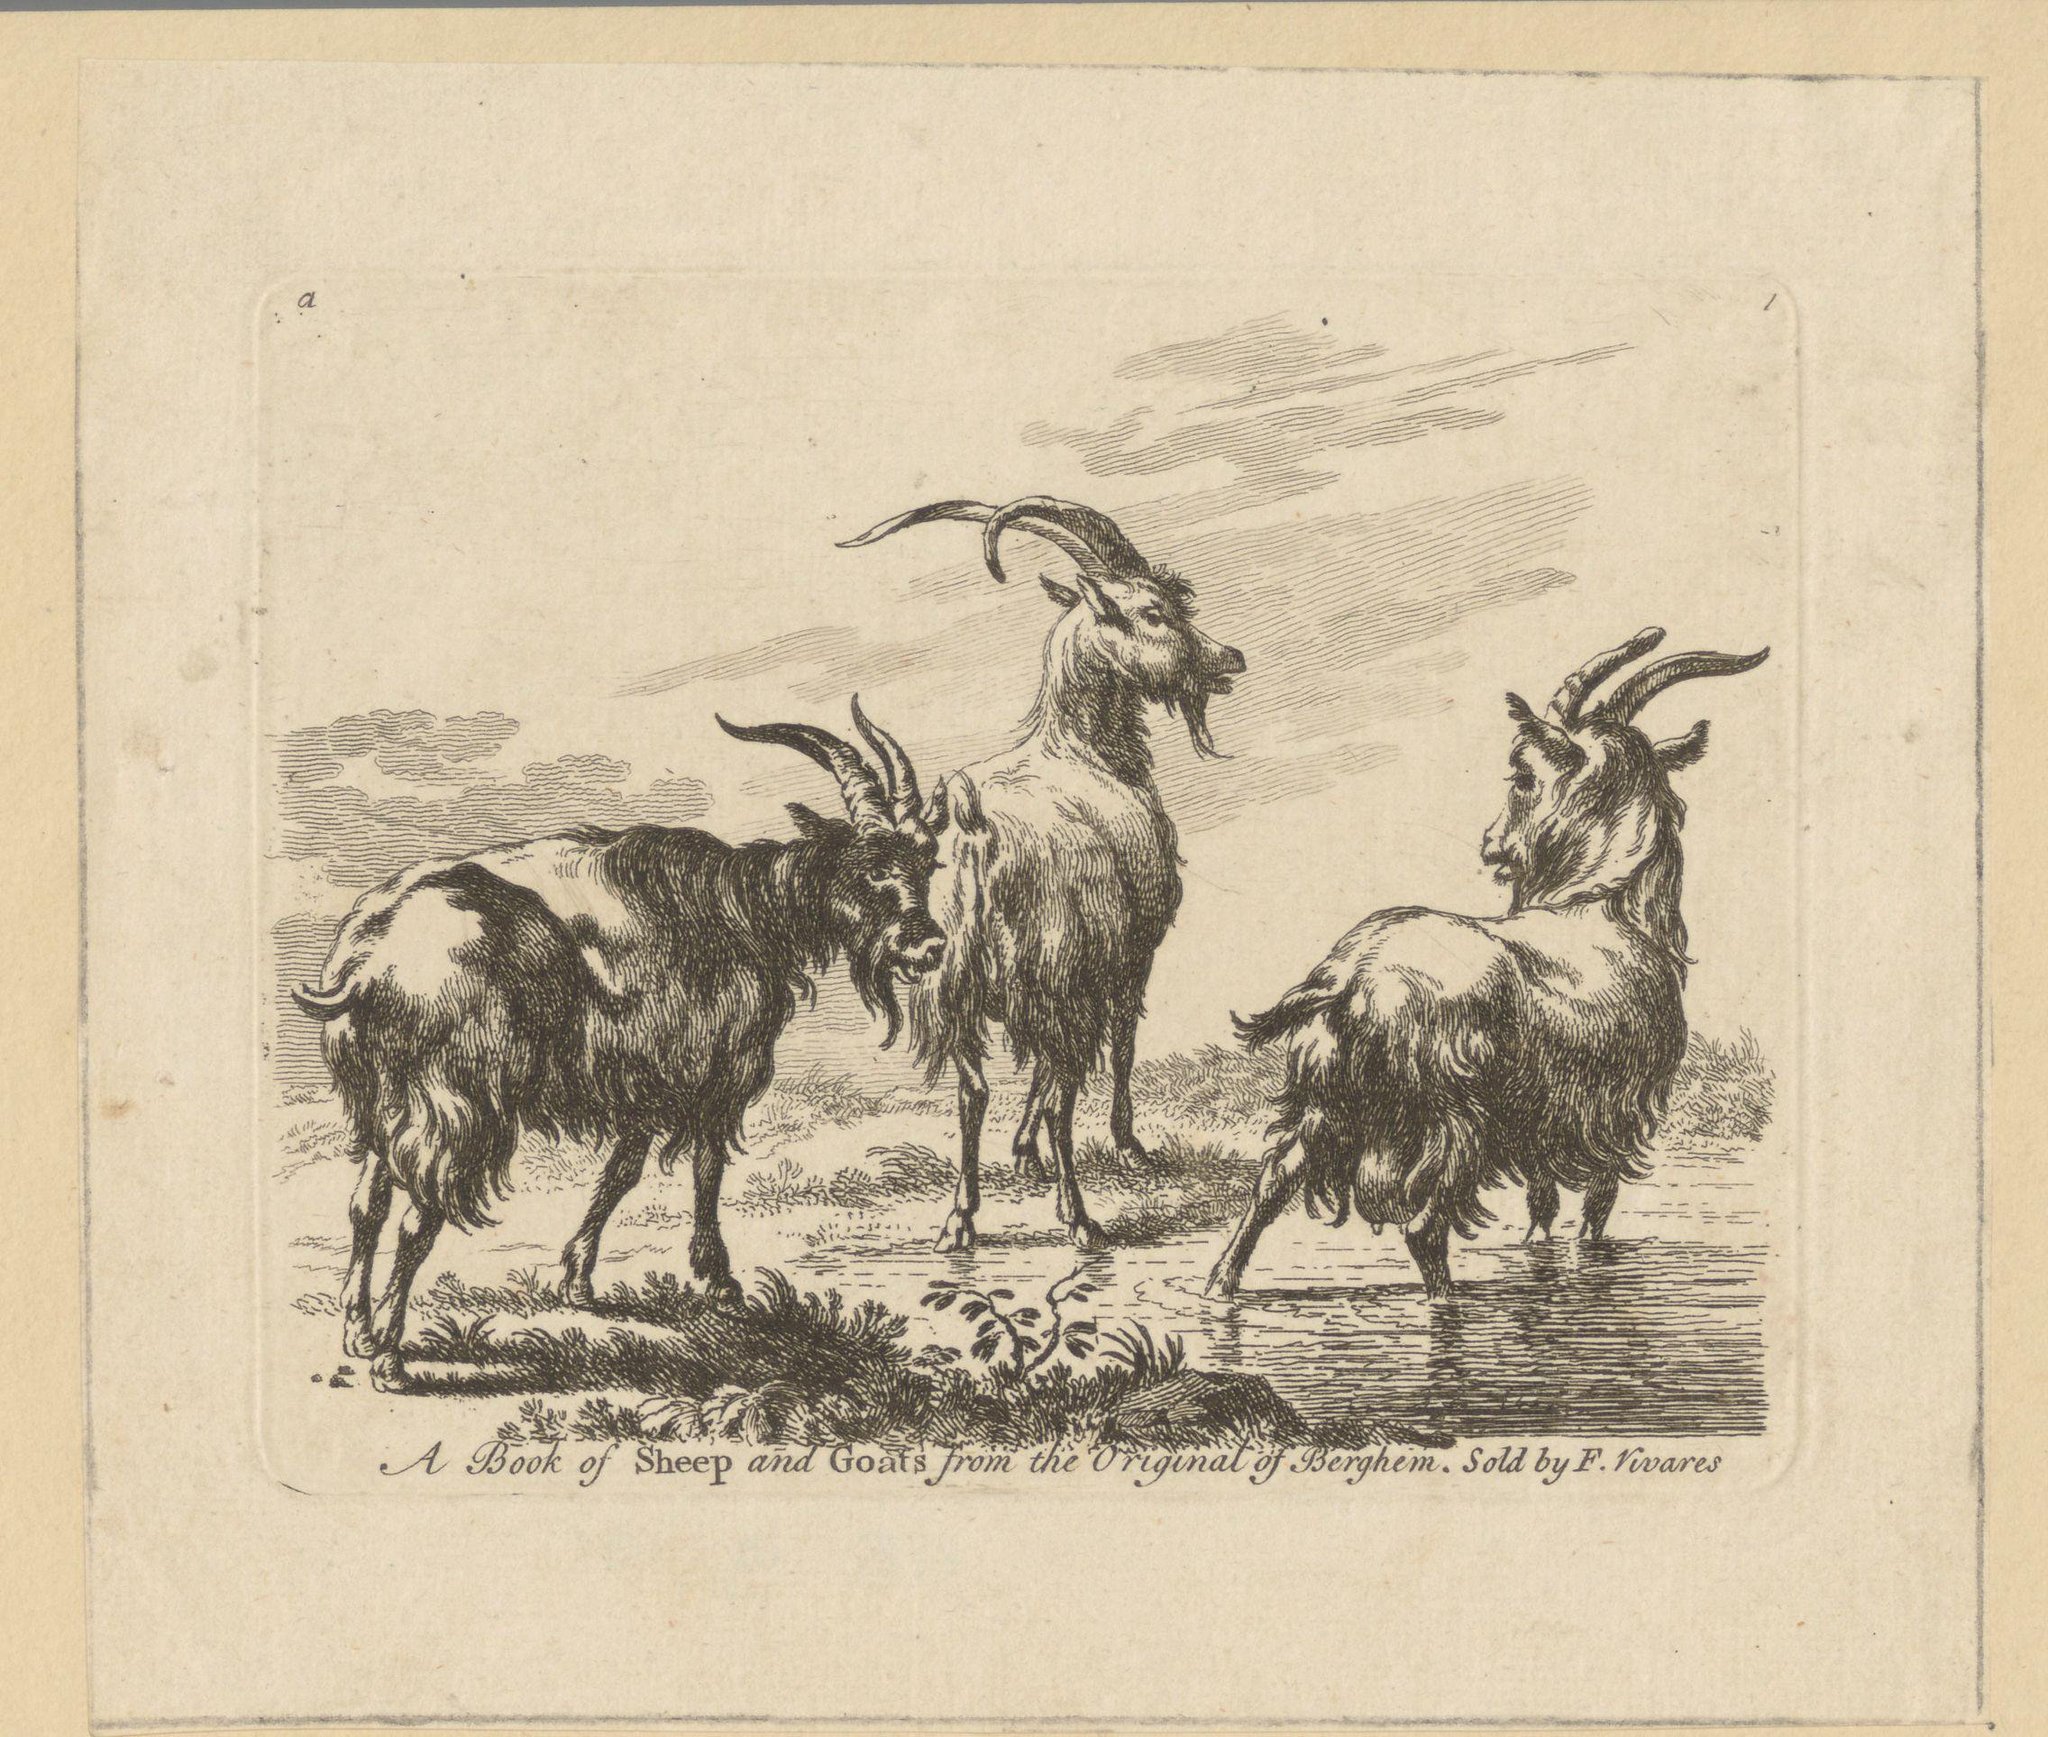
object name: print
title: Drie geiten bij een oever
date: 1719-1780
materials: paper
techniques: etching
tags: river bank, sheep, goat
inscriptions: collector's mark: Lugt 240